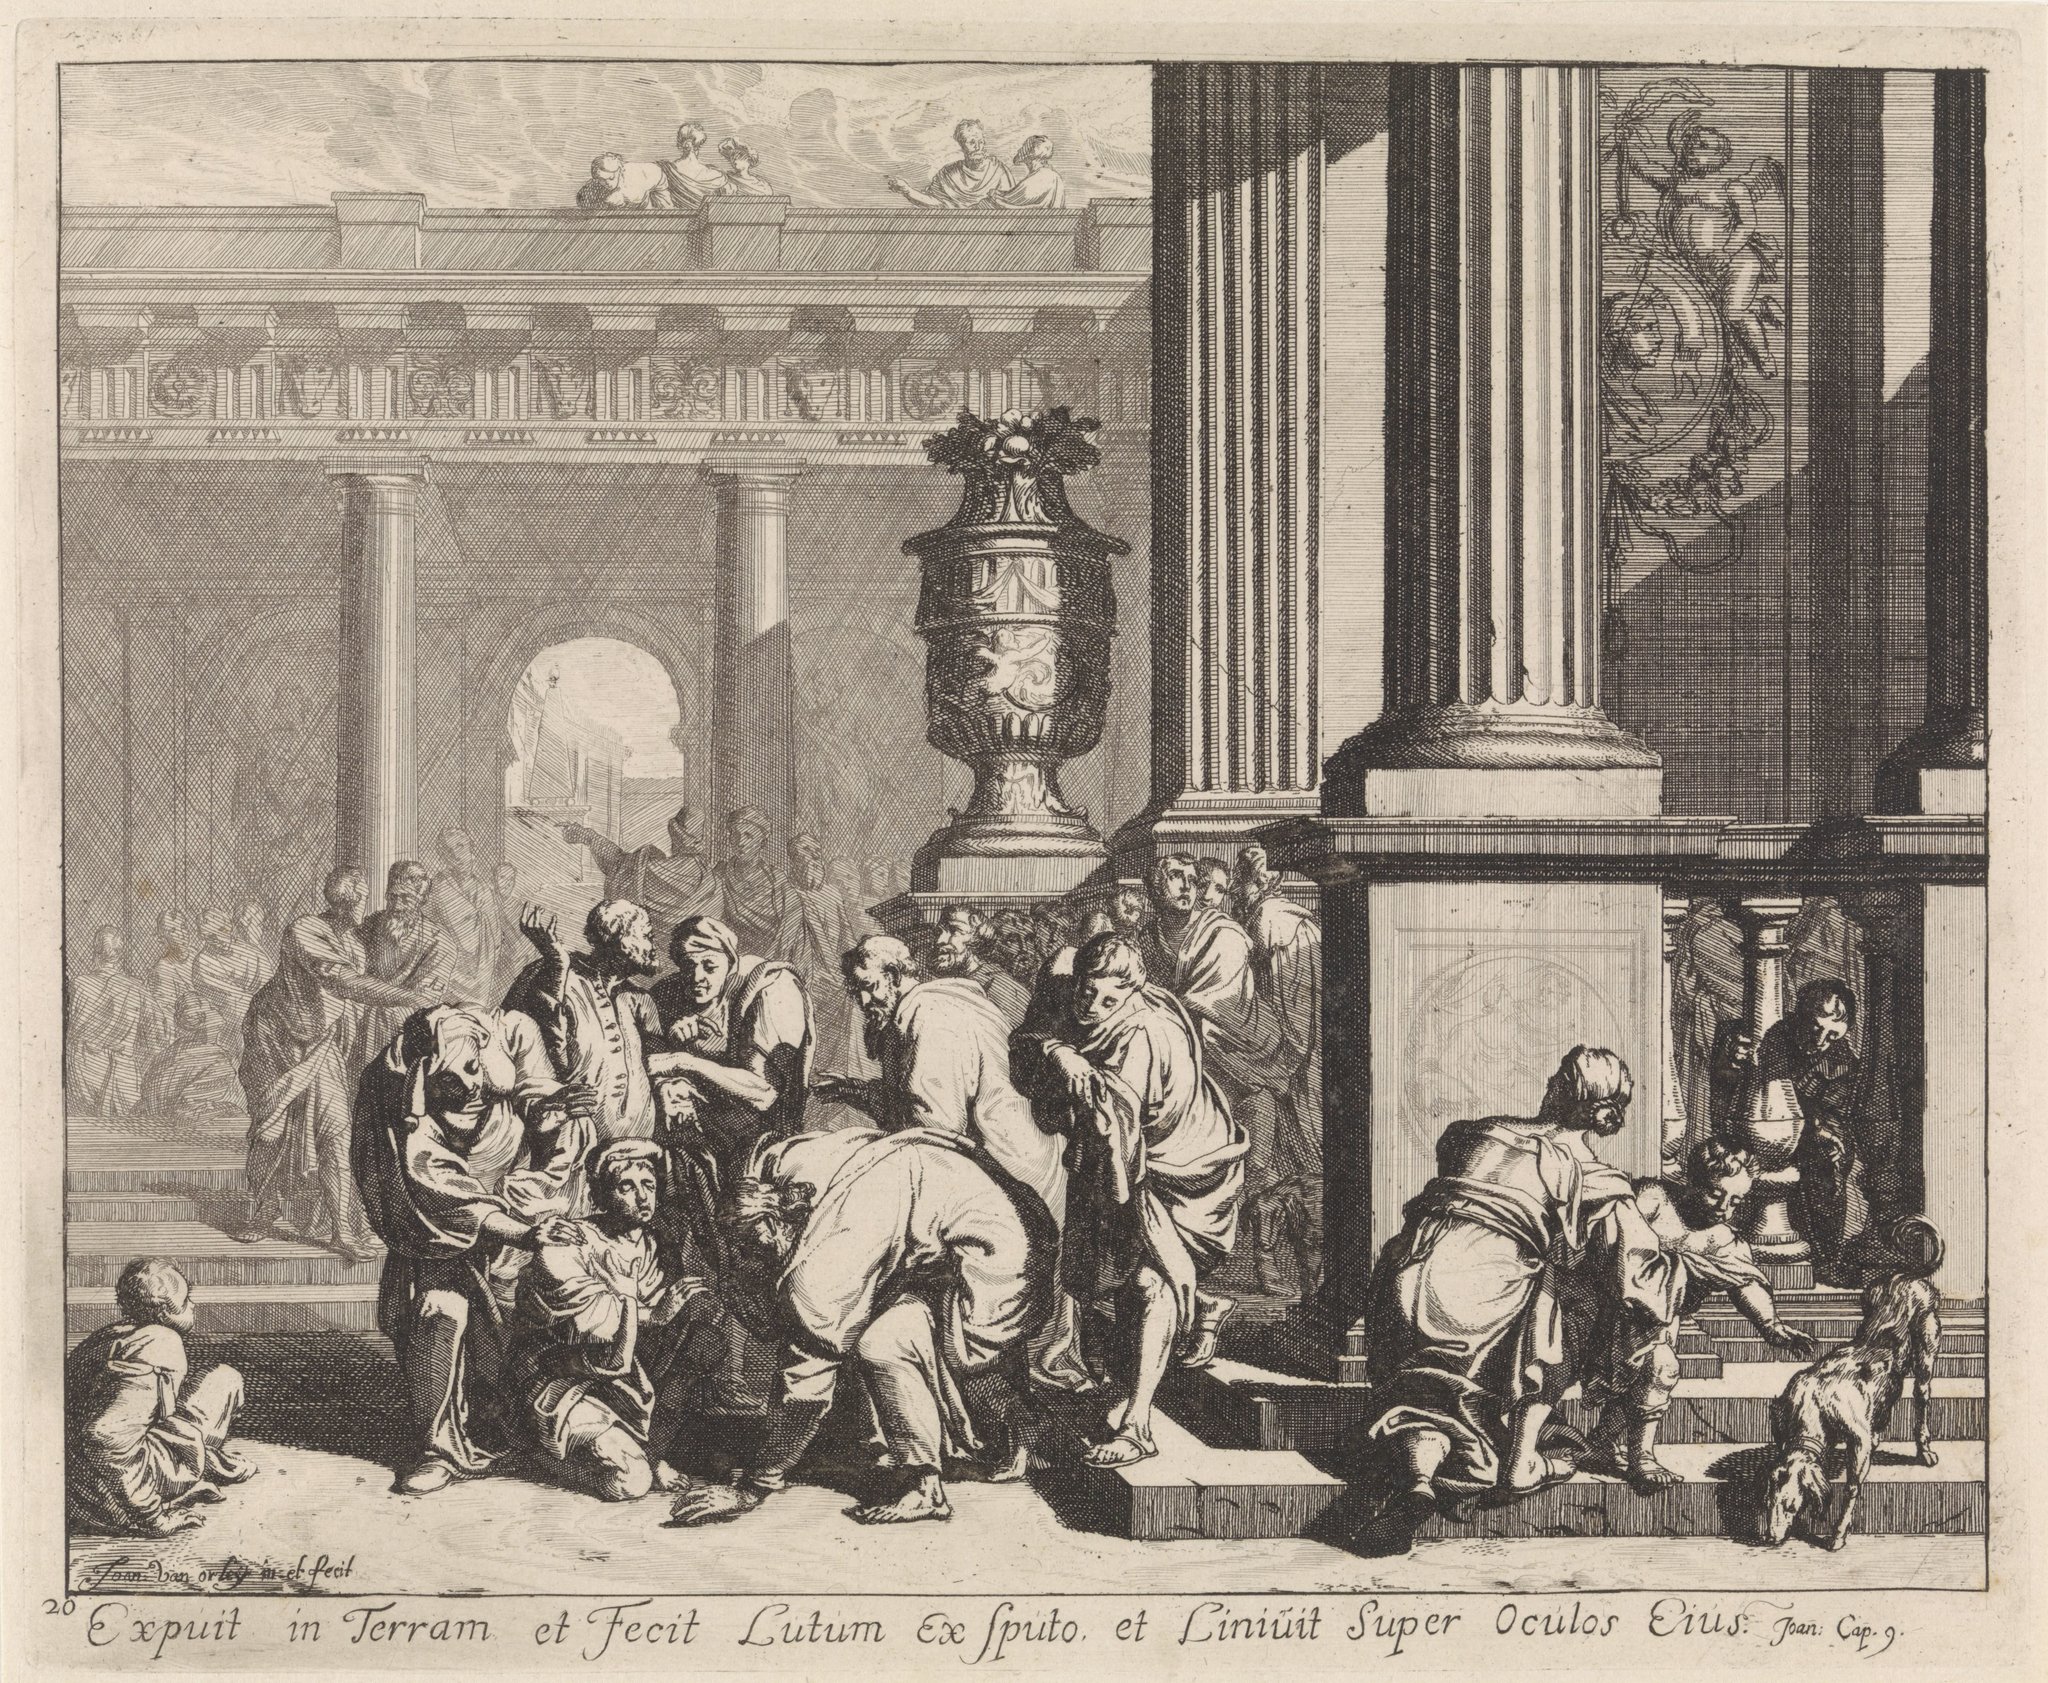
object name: print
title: Christus geneest de blinde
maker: jan van orley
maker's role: print maker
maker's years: 1665-1735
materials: paper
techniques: engraving, etching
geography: brussels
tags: healing of a man born blind: christ touches his eyes with an 'ointment' of dust and spittle (john 9)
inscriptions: collector's mark: Lugt 240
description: Christus raapt stof en zand van de grond en strooit het in de ogen van een blindgeboren man. De blinde man knielt op de grond voor Christus. Christus discipelen staan om hem heen en kijken naar de genezing. Onder de afbeelding een Latijns vers uit Joh. 9.